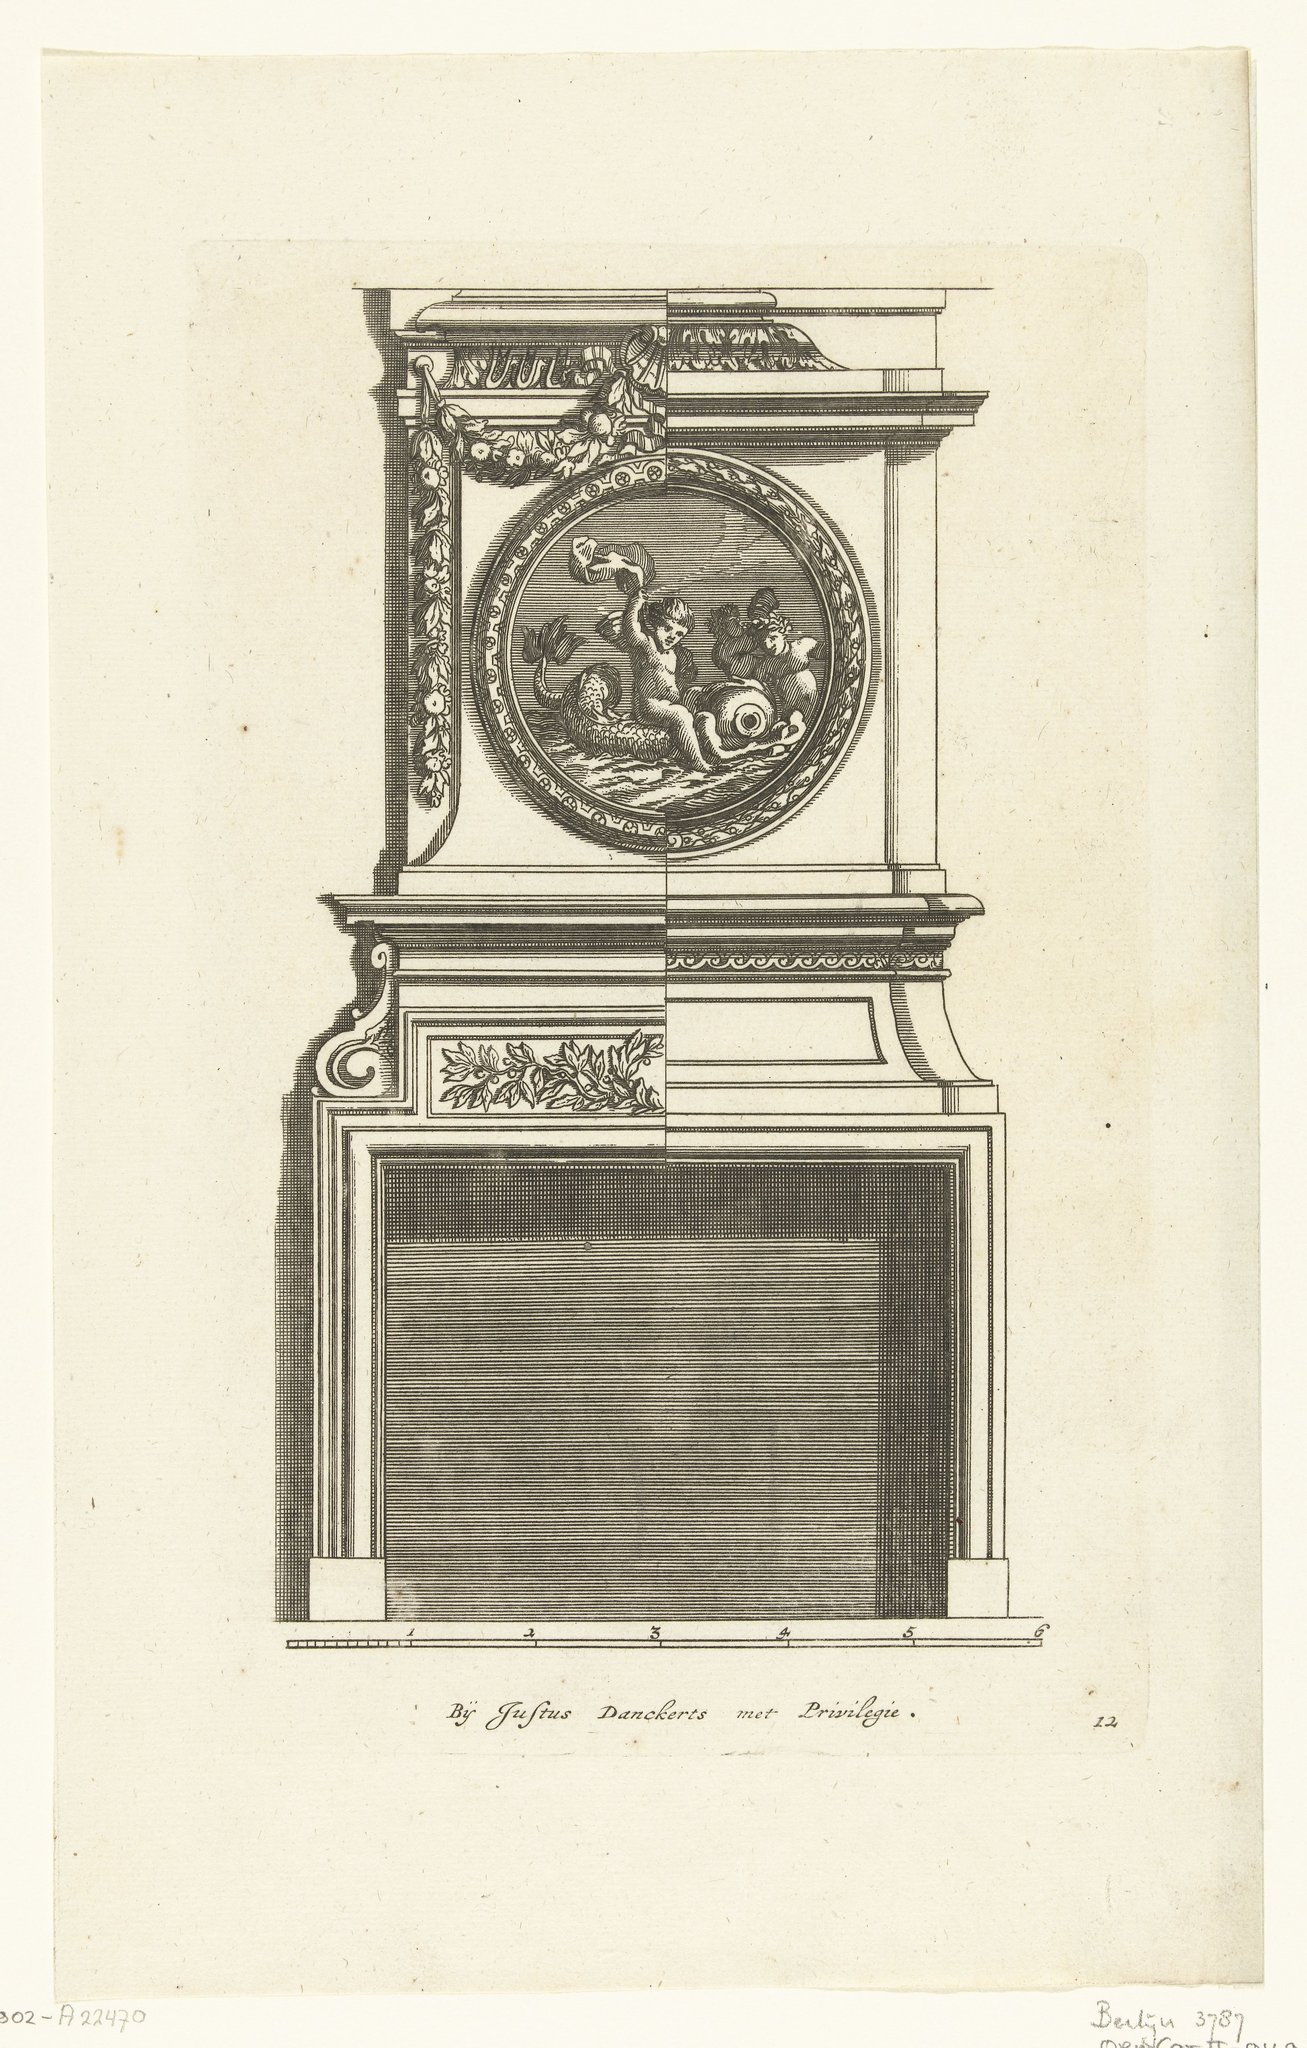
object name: ornament print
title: Onderboezem met variant voor rechterhelft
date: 1675-1686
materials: paper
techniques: etching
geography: netherlands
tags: chimney-piece, mantelpiece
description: Bovenaan hangt een rond medaillon met een putto op een dolfijn.